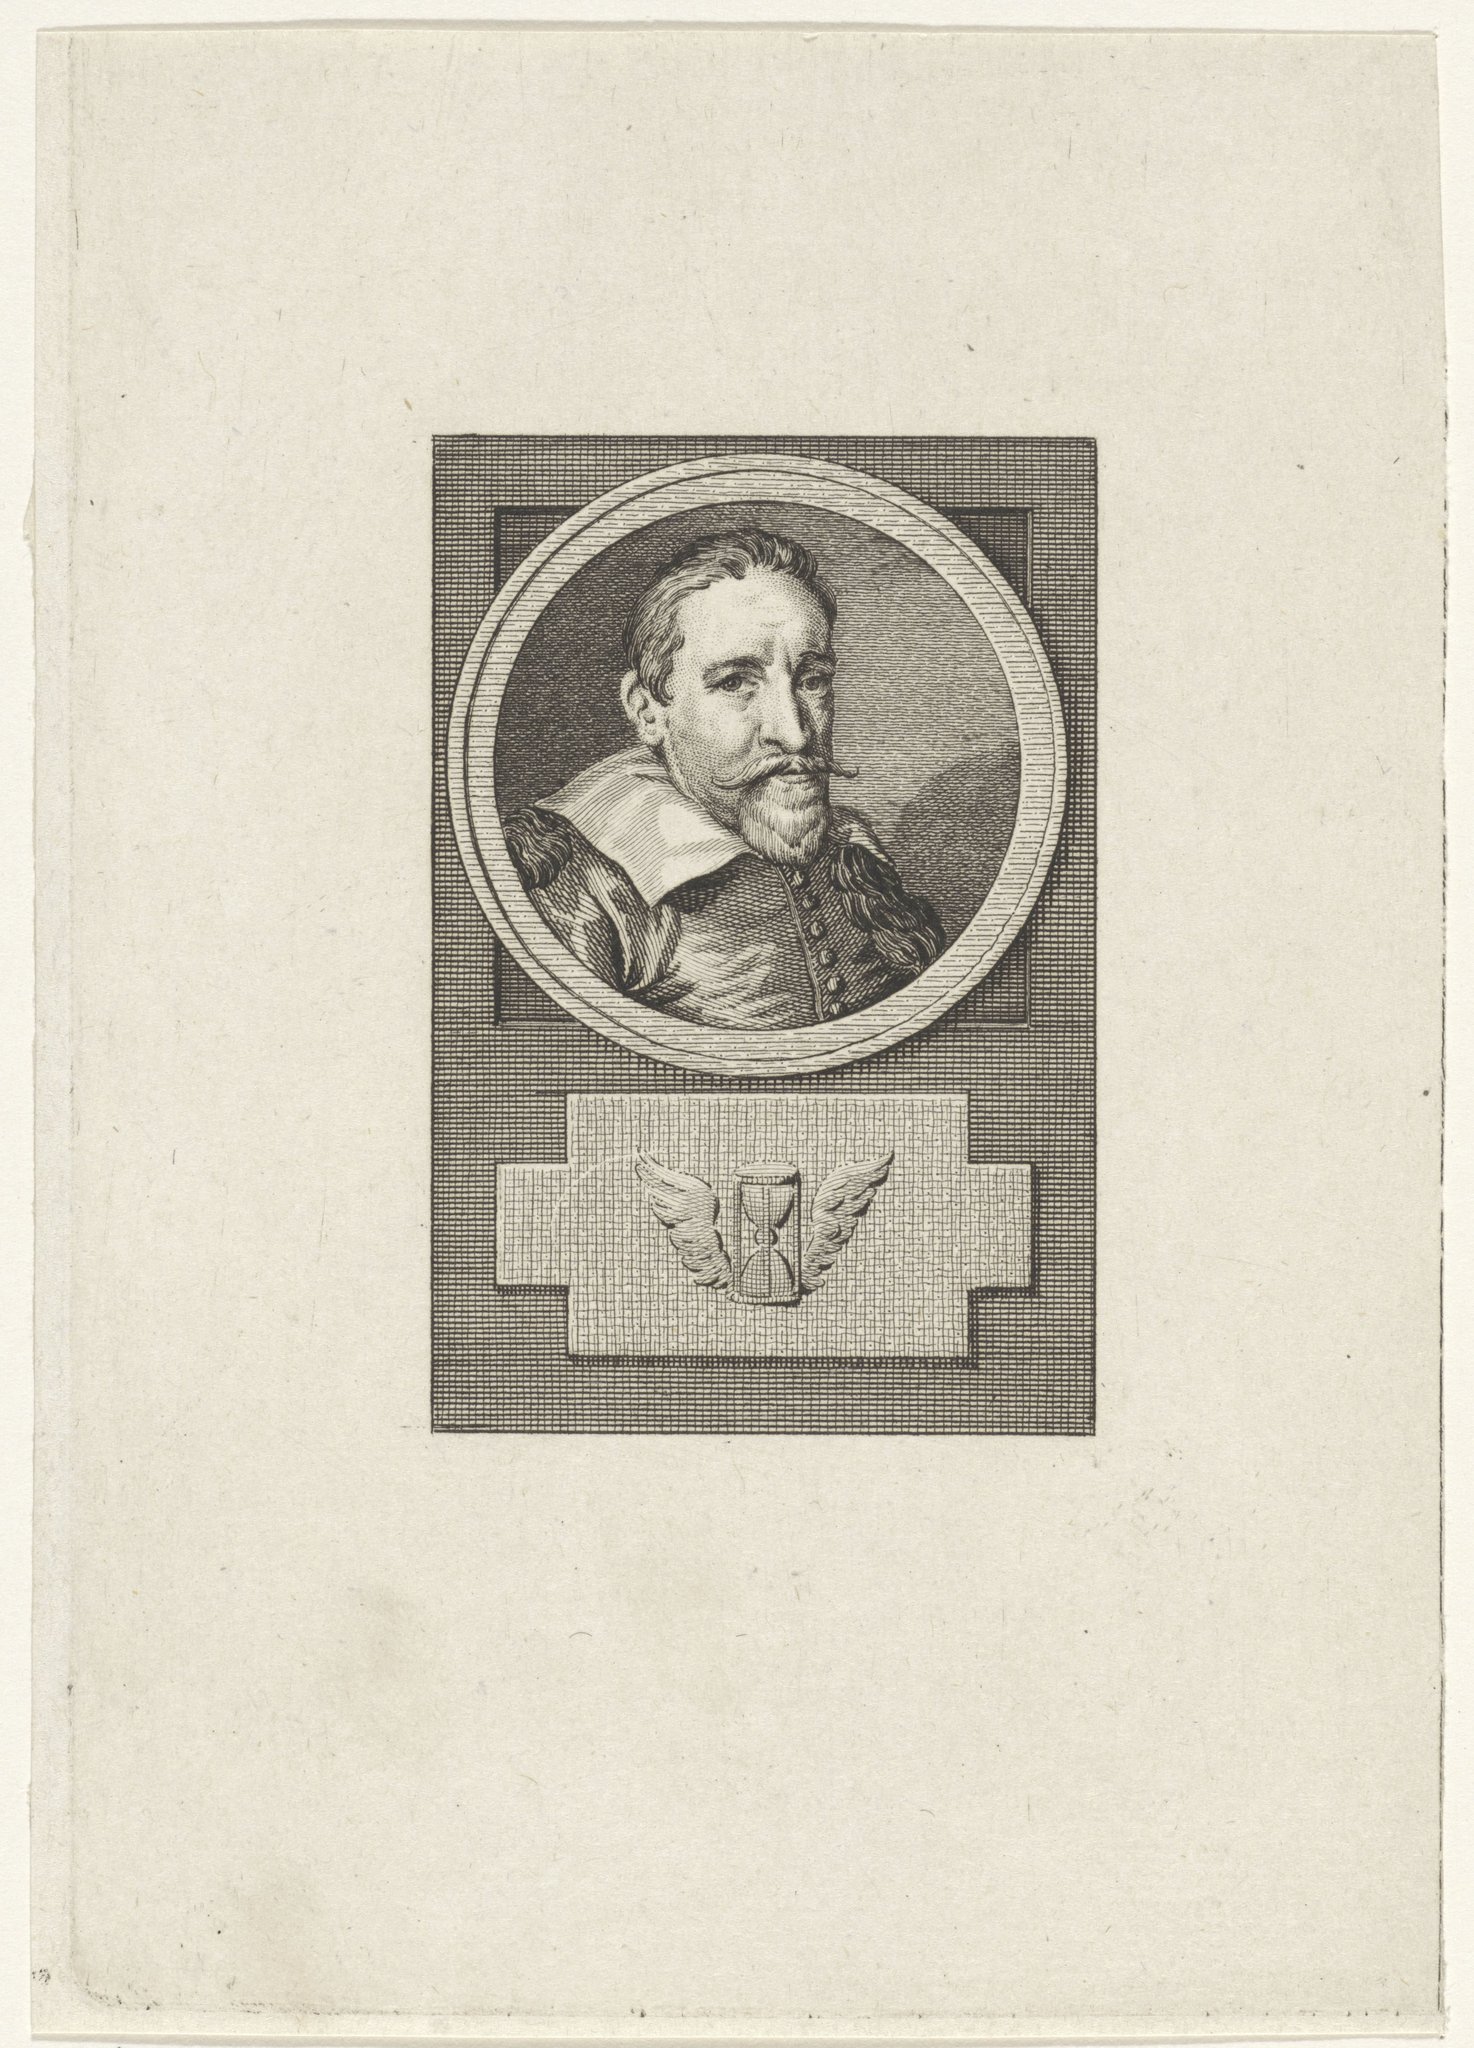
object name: print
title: Portret van Jan Neyen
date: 1783-1795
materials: paper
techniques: engraving, etching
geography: amsterdam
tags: antwerp, spain, hourglass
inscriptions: collector's mark: Lugt 2228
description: Latere staat prent gebruikt in: Fokke, Jan. Geschiedenissen der Vereenigde Nederlanden voor de vaderlandsche jeugd Ie-XXVste deel. Amsterdam: Johannes Allart, 1783-1795. Deel VI.